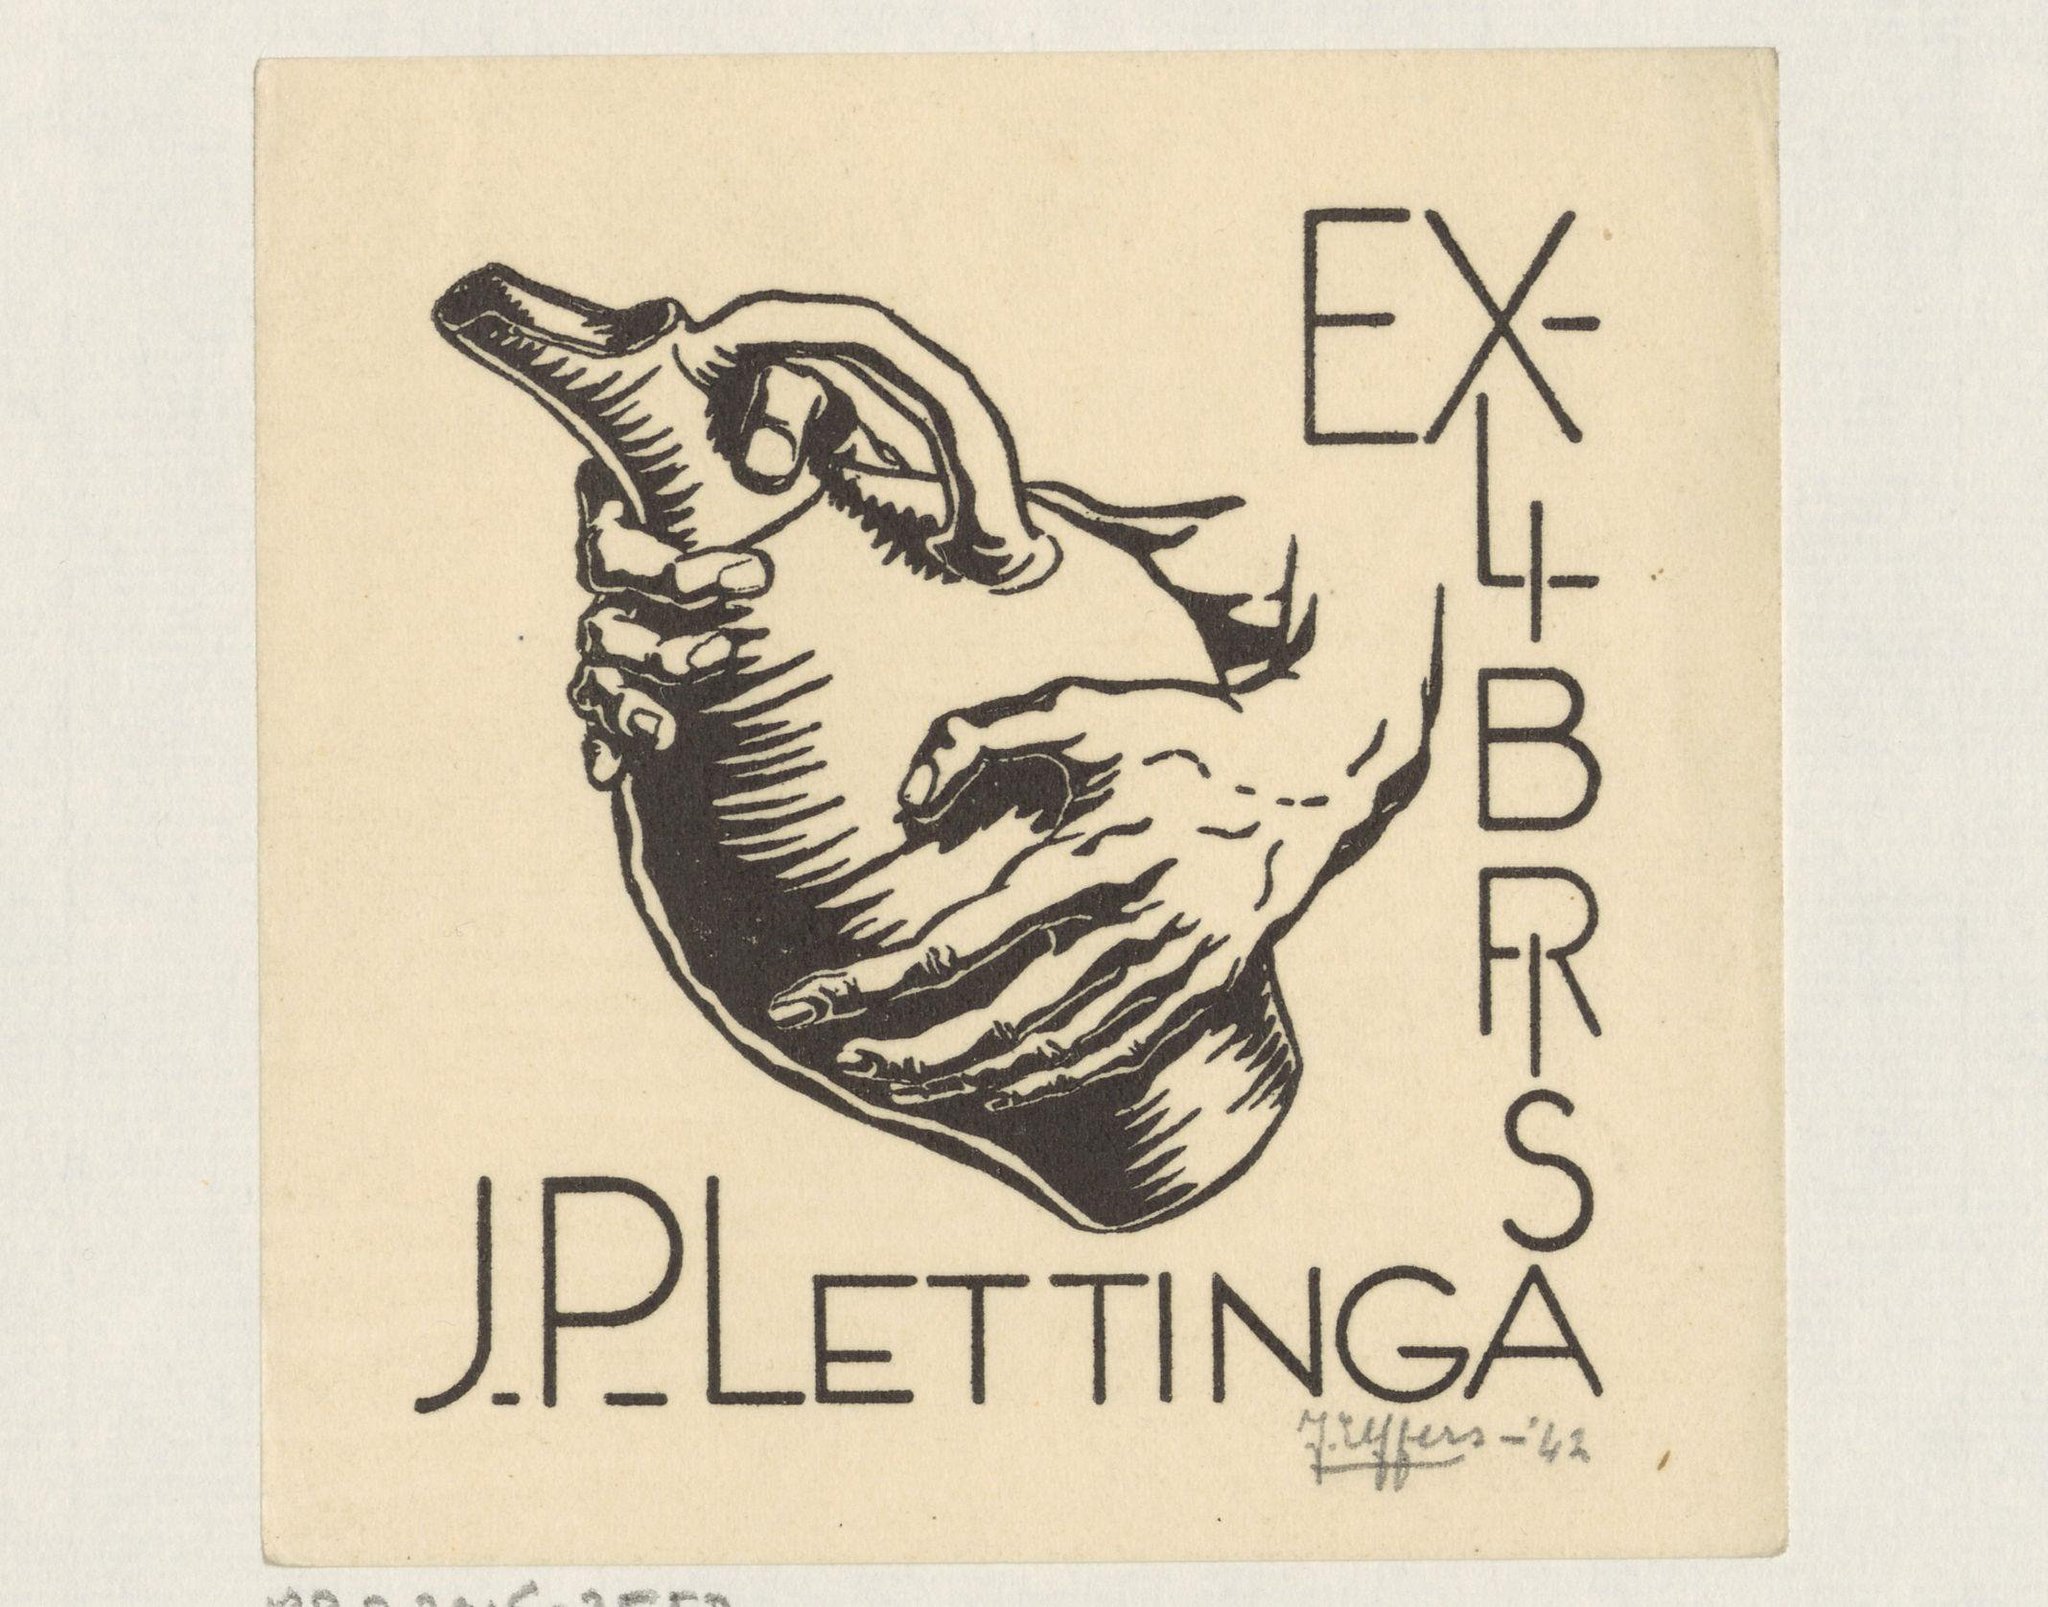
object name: bookplate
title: Ex libris van J.P. Lettinga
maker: jan elffers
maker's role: print maker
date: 1942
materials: paper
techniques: printing block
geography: netherlands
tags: container of ceramics: jar, jug, pot, vase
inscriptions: signature and date: ‘J. Elffers - '42’